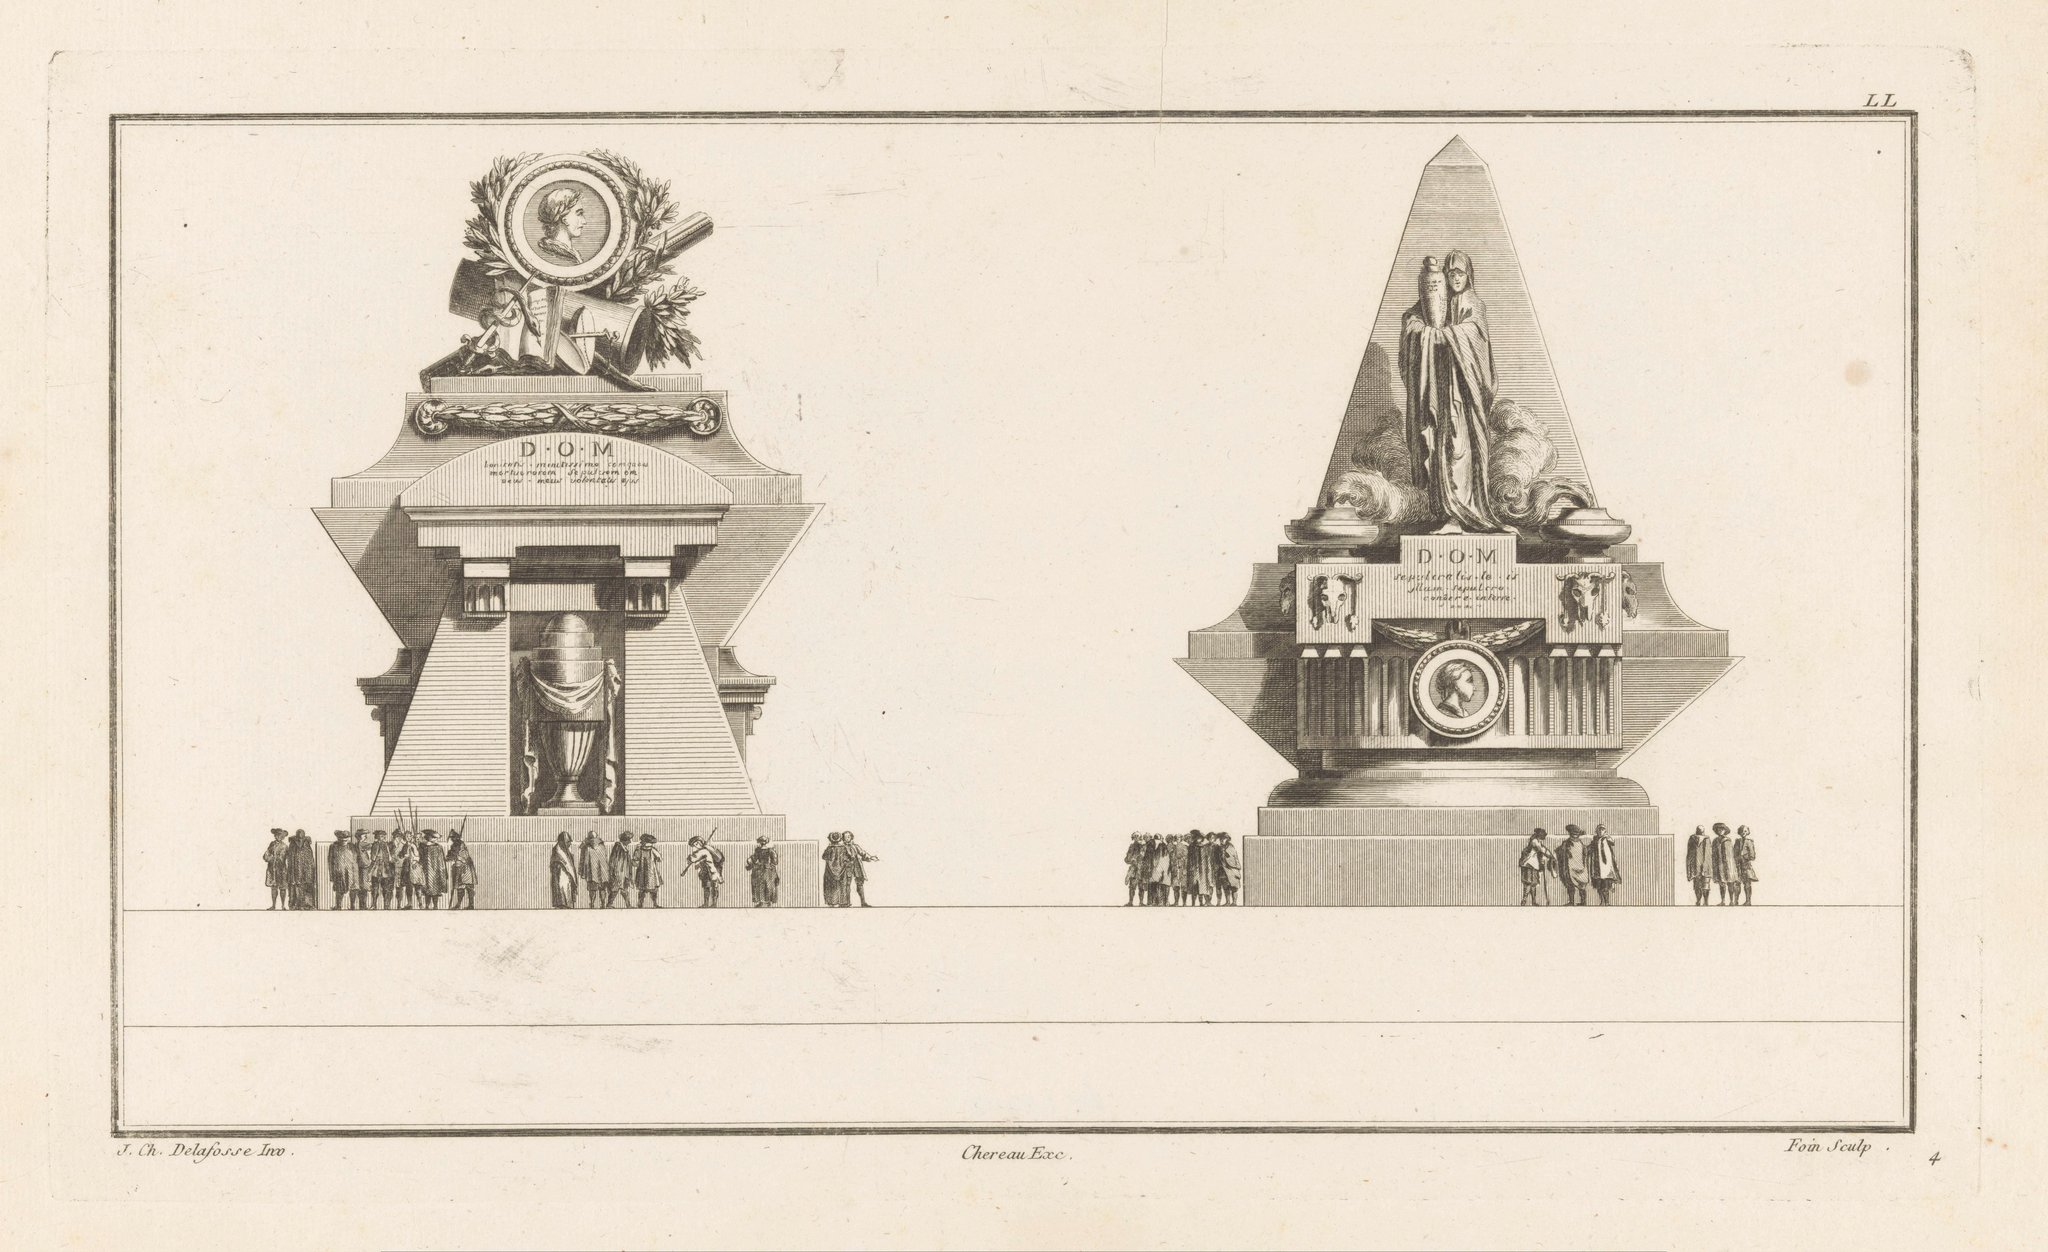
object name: print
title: IIe Volume De l'Oeuvre de J. Ch. Delafosse (...)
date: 1771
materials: paper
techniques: engraving, etching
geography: paris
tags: grave, tomb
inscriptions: collector's mark: Lugt 2760, collector's mark: Lugt 2228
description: Links een tombe met een urn in een nis en een medaillon met portret en profiel. Rechts een tombe met een rond medaillon met portret en profil, bucraniums, rookvaten en een staande vrouw met een urn.